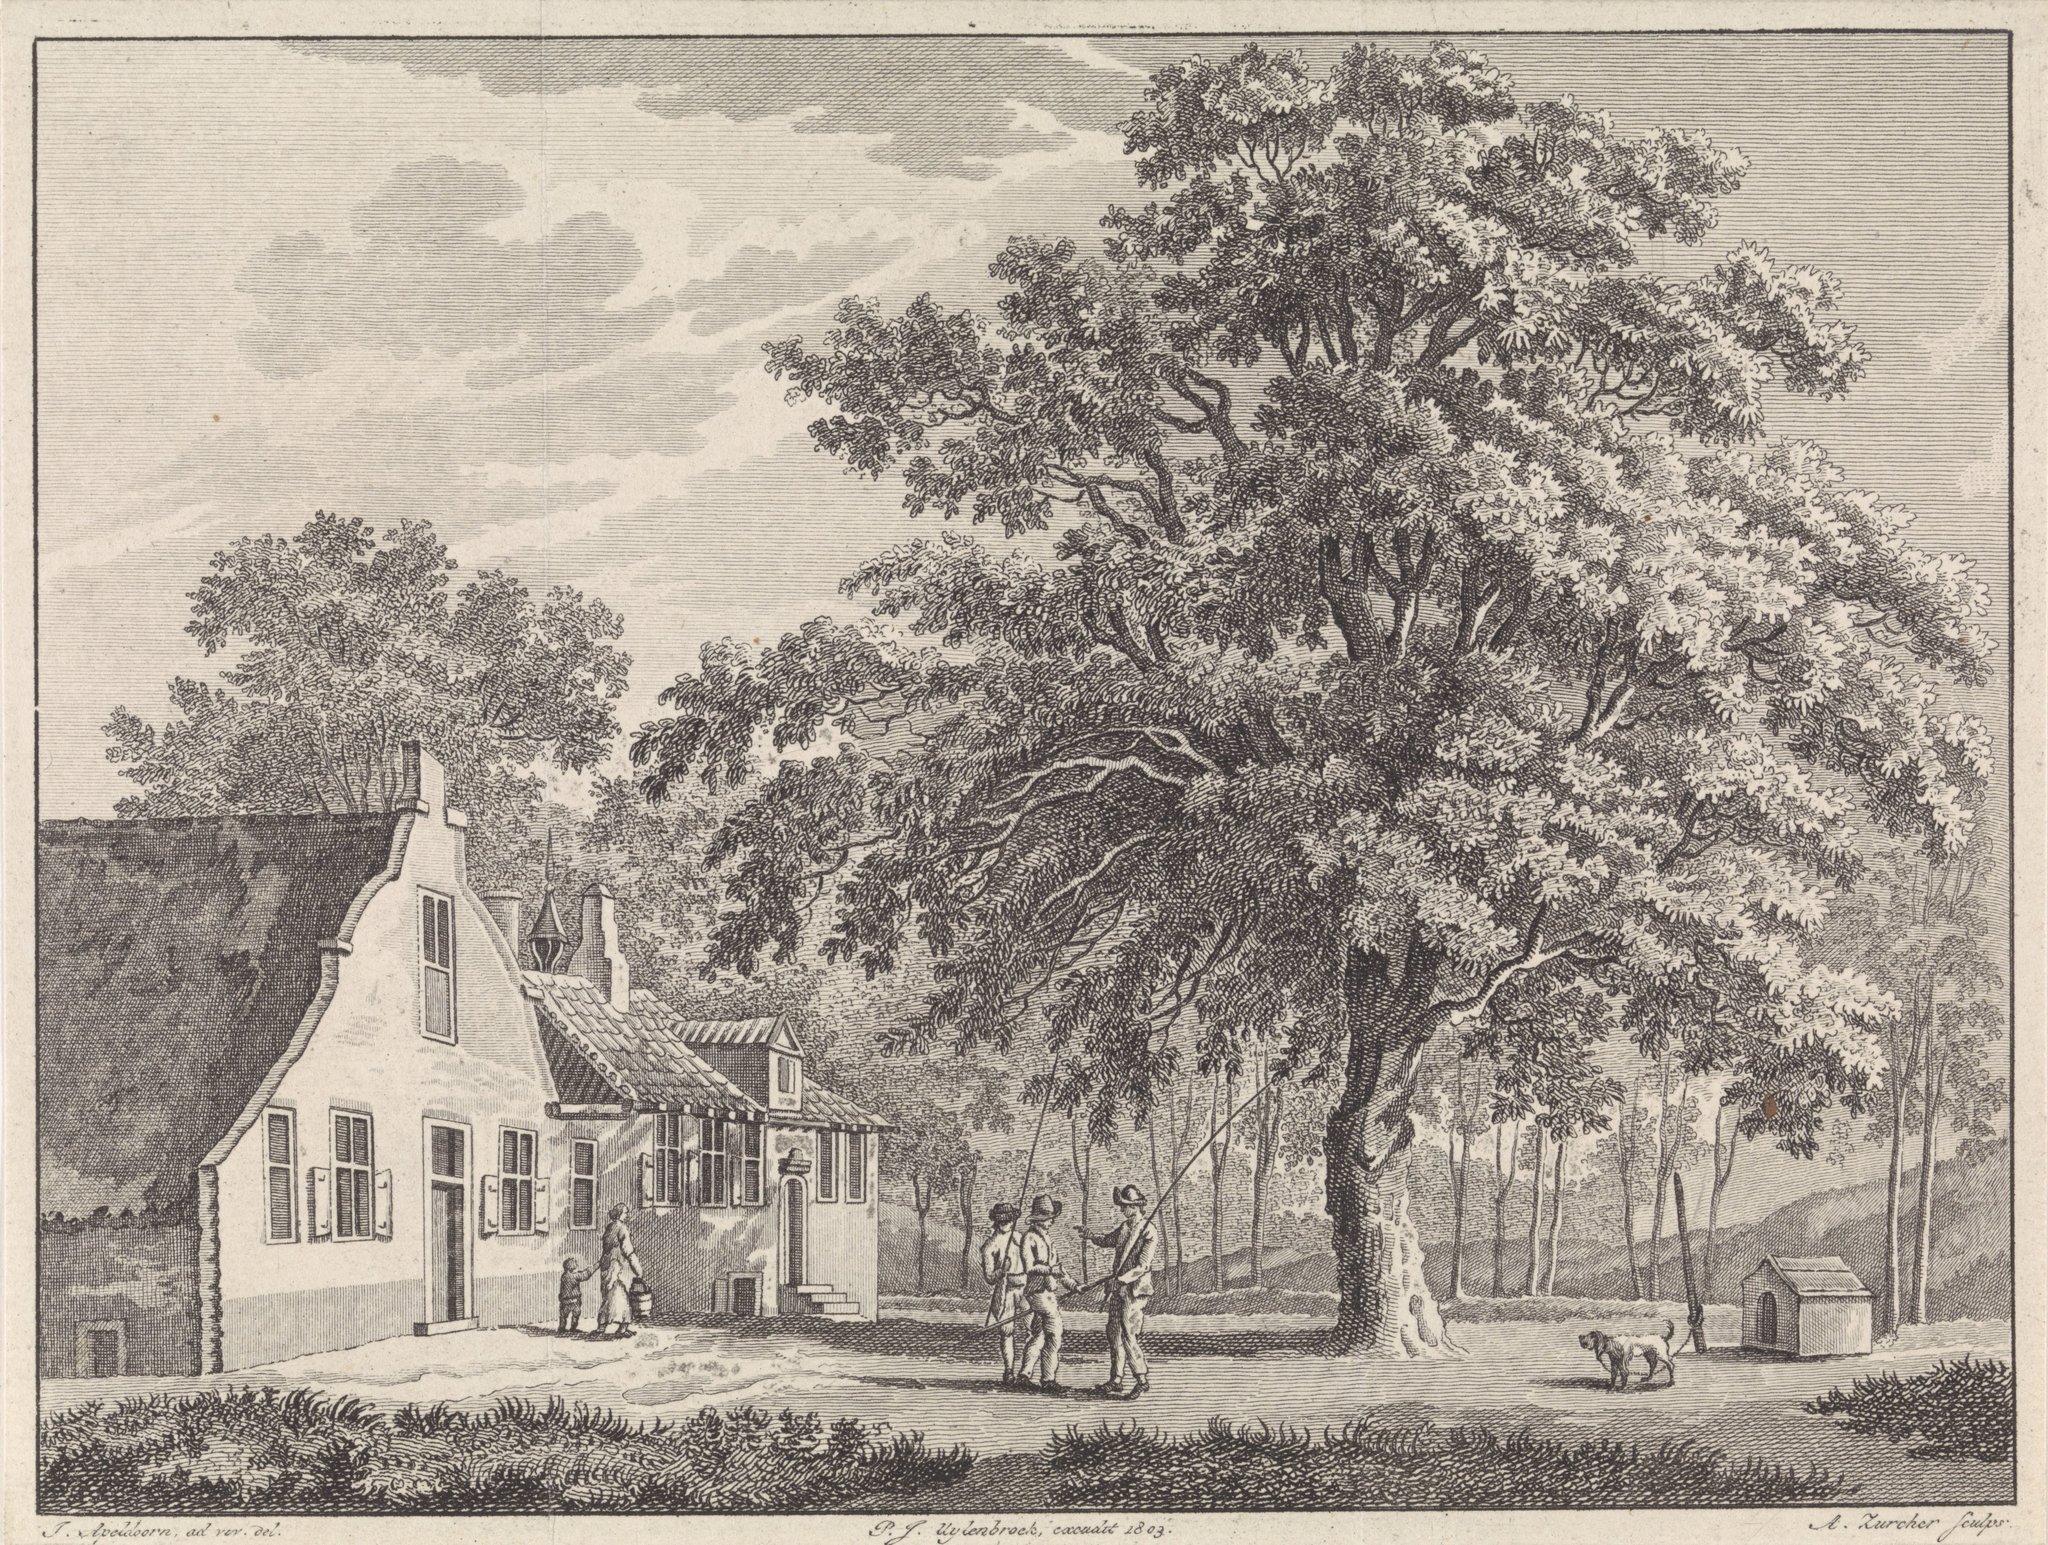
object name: print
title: Boerderij en boom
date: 1803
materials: paper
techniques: etching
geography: amsterdam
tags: trees, farm or solitary house in landscape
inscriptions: collector's mark: Lugt 2228, collector's mark: Lugt 2760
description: Landschap met links een boerderij en rechts een hoge boom. Bij het huis loopt een vrouw met kind. Onder de boom staan drie mannen bijeen. Rechts een hond bij zijn hok.